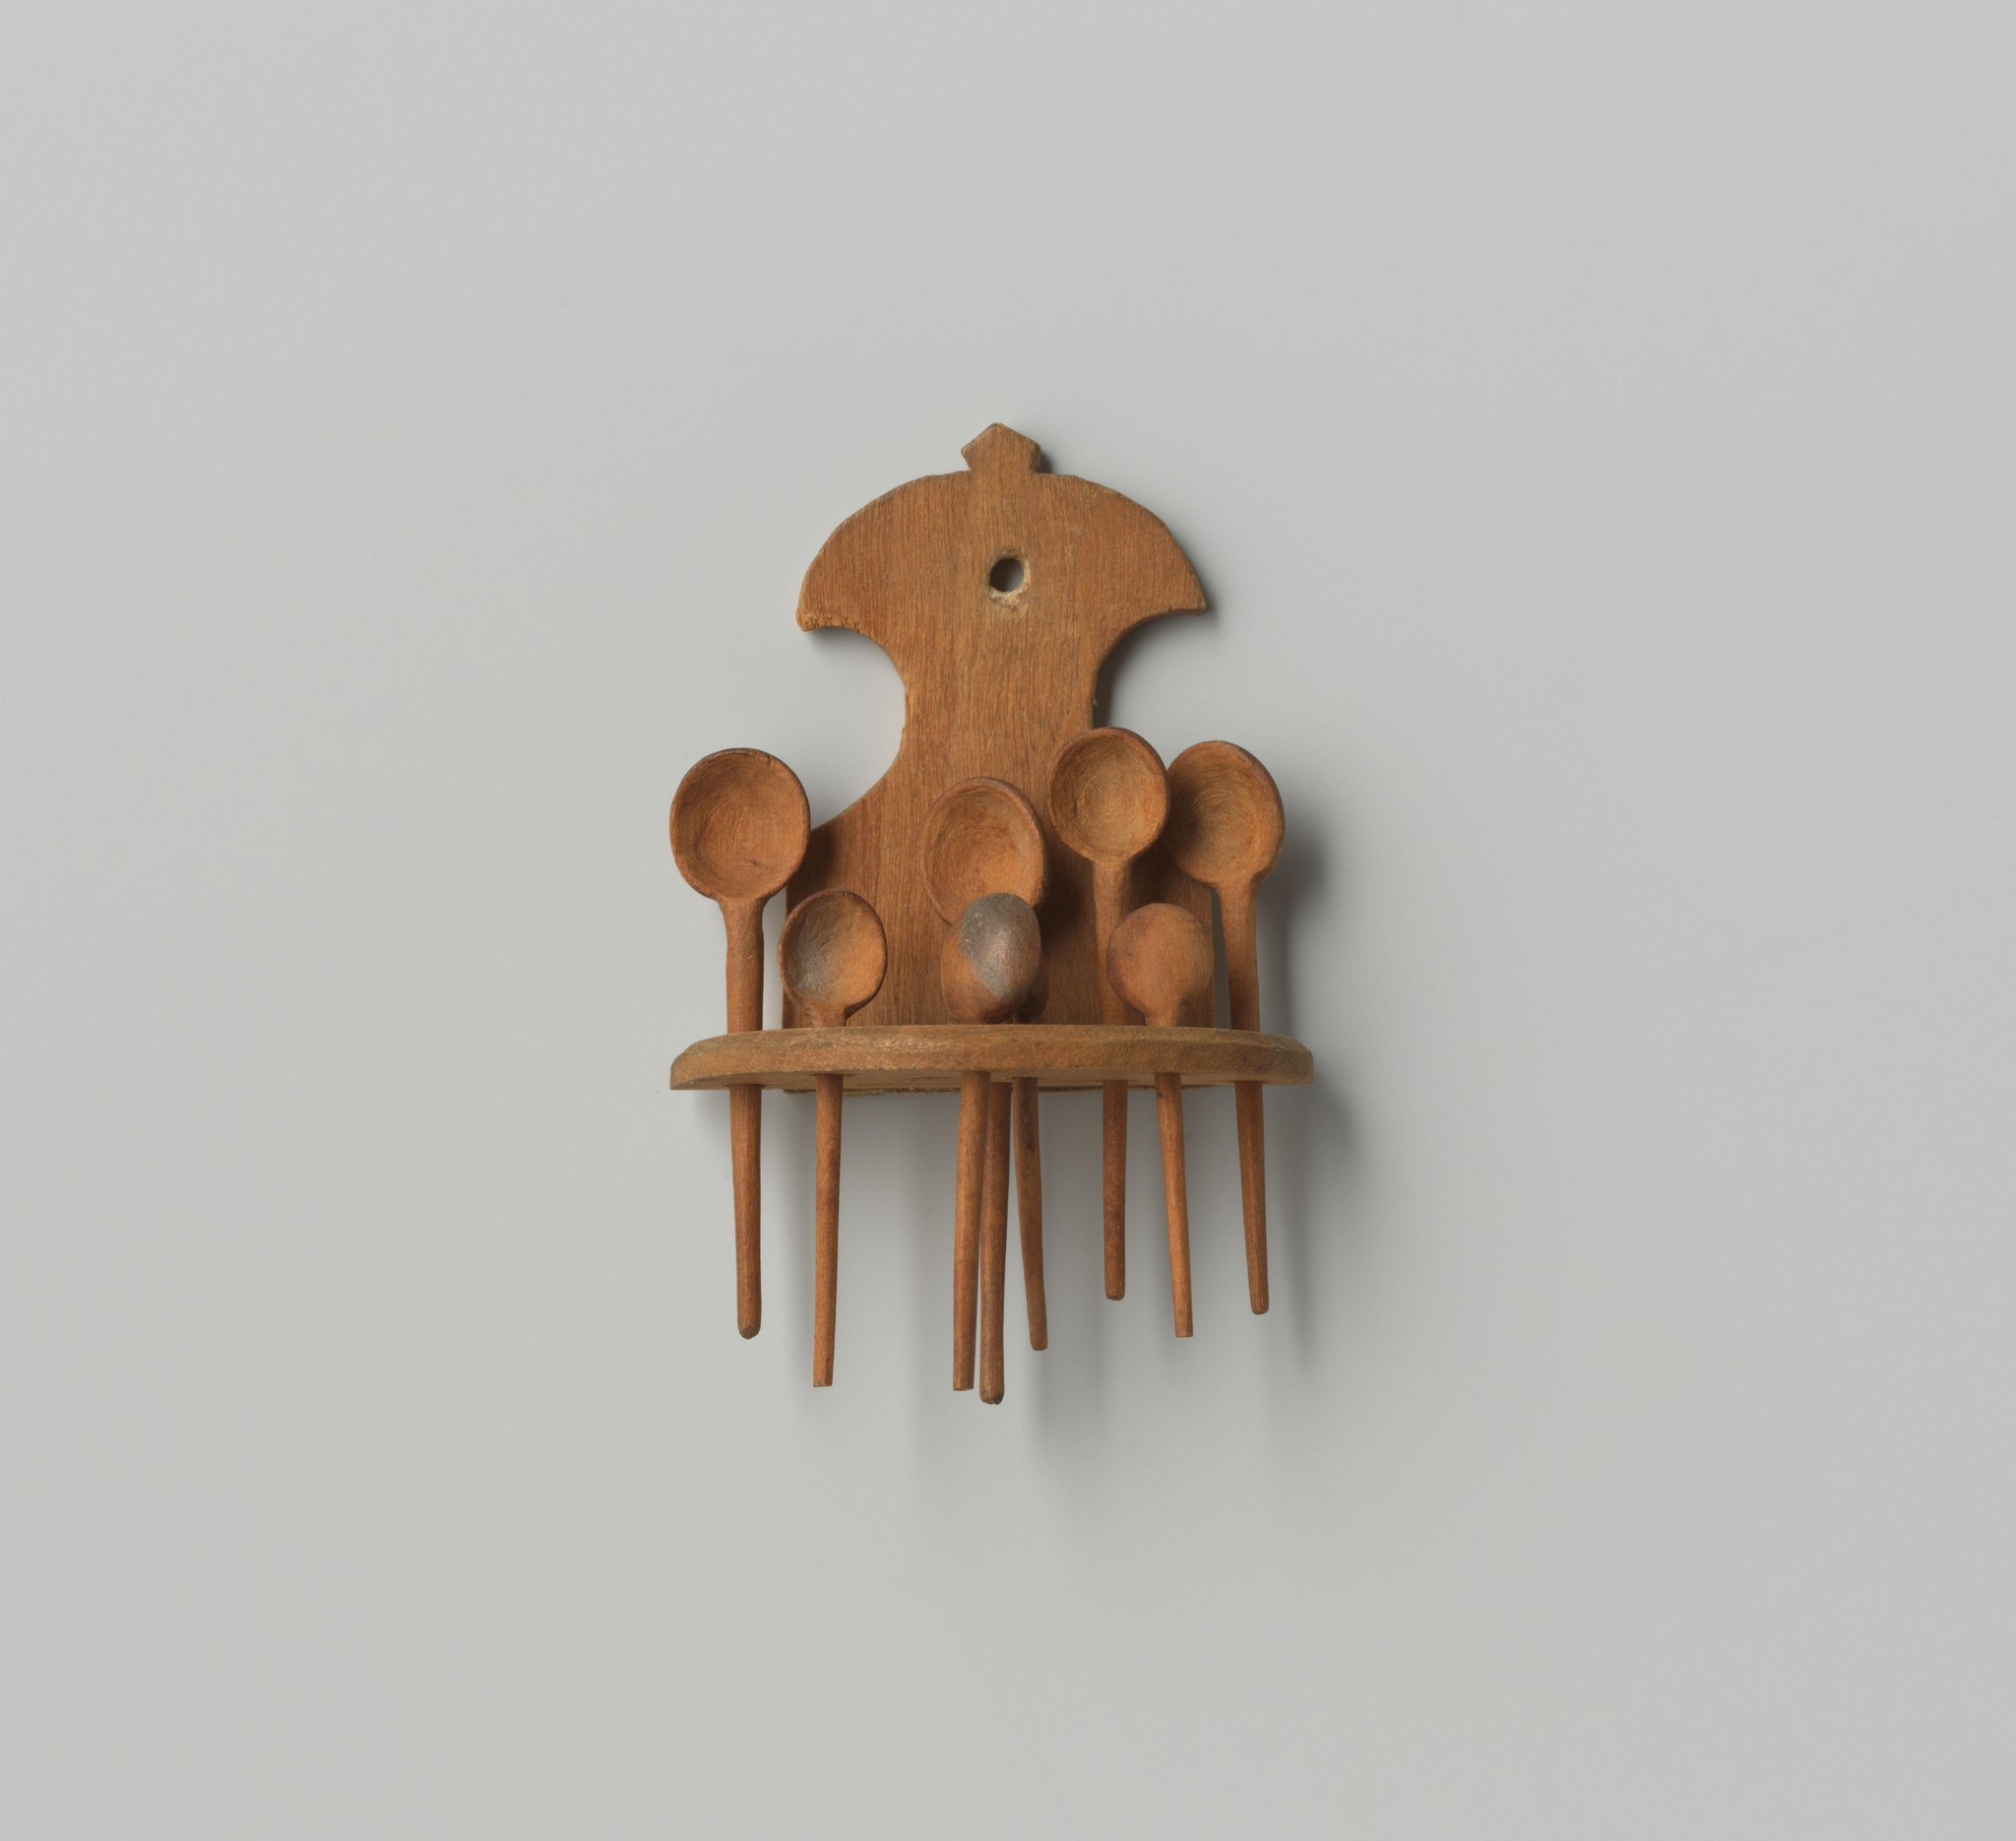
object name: spoon stand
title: Lepelrek van 'without', bestaande uit een achterplaat met oog en halfronde plaat met tien gaten, waarin acht lepels van esdoornhout.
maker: Anonymous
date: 1680-1710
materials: wood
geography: amsterdam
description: Lepelrek van 'without' bestaande uit een achterplaat met oog en halfronde plaat met tien gaten, waarin acht lepels van esdoornhout.